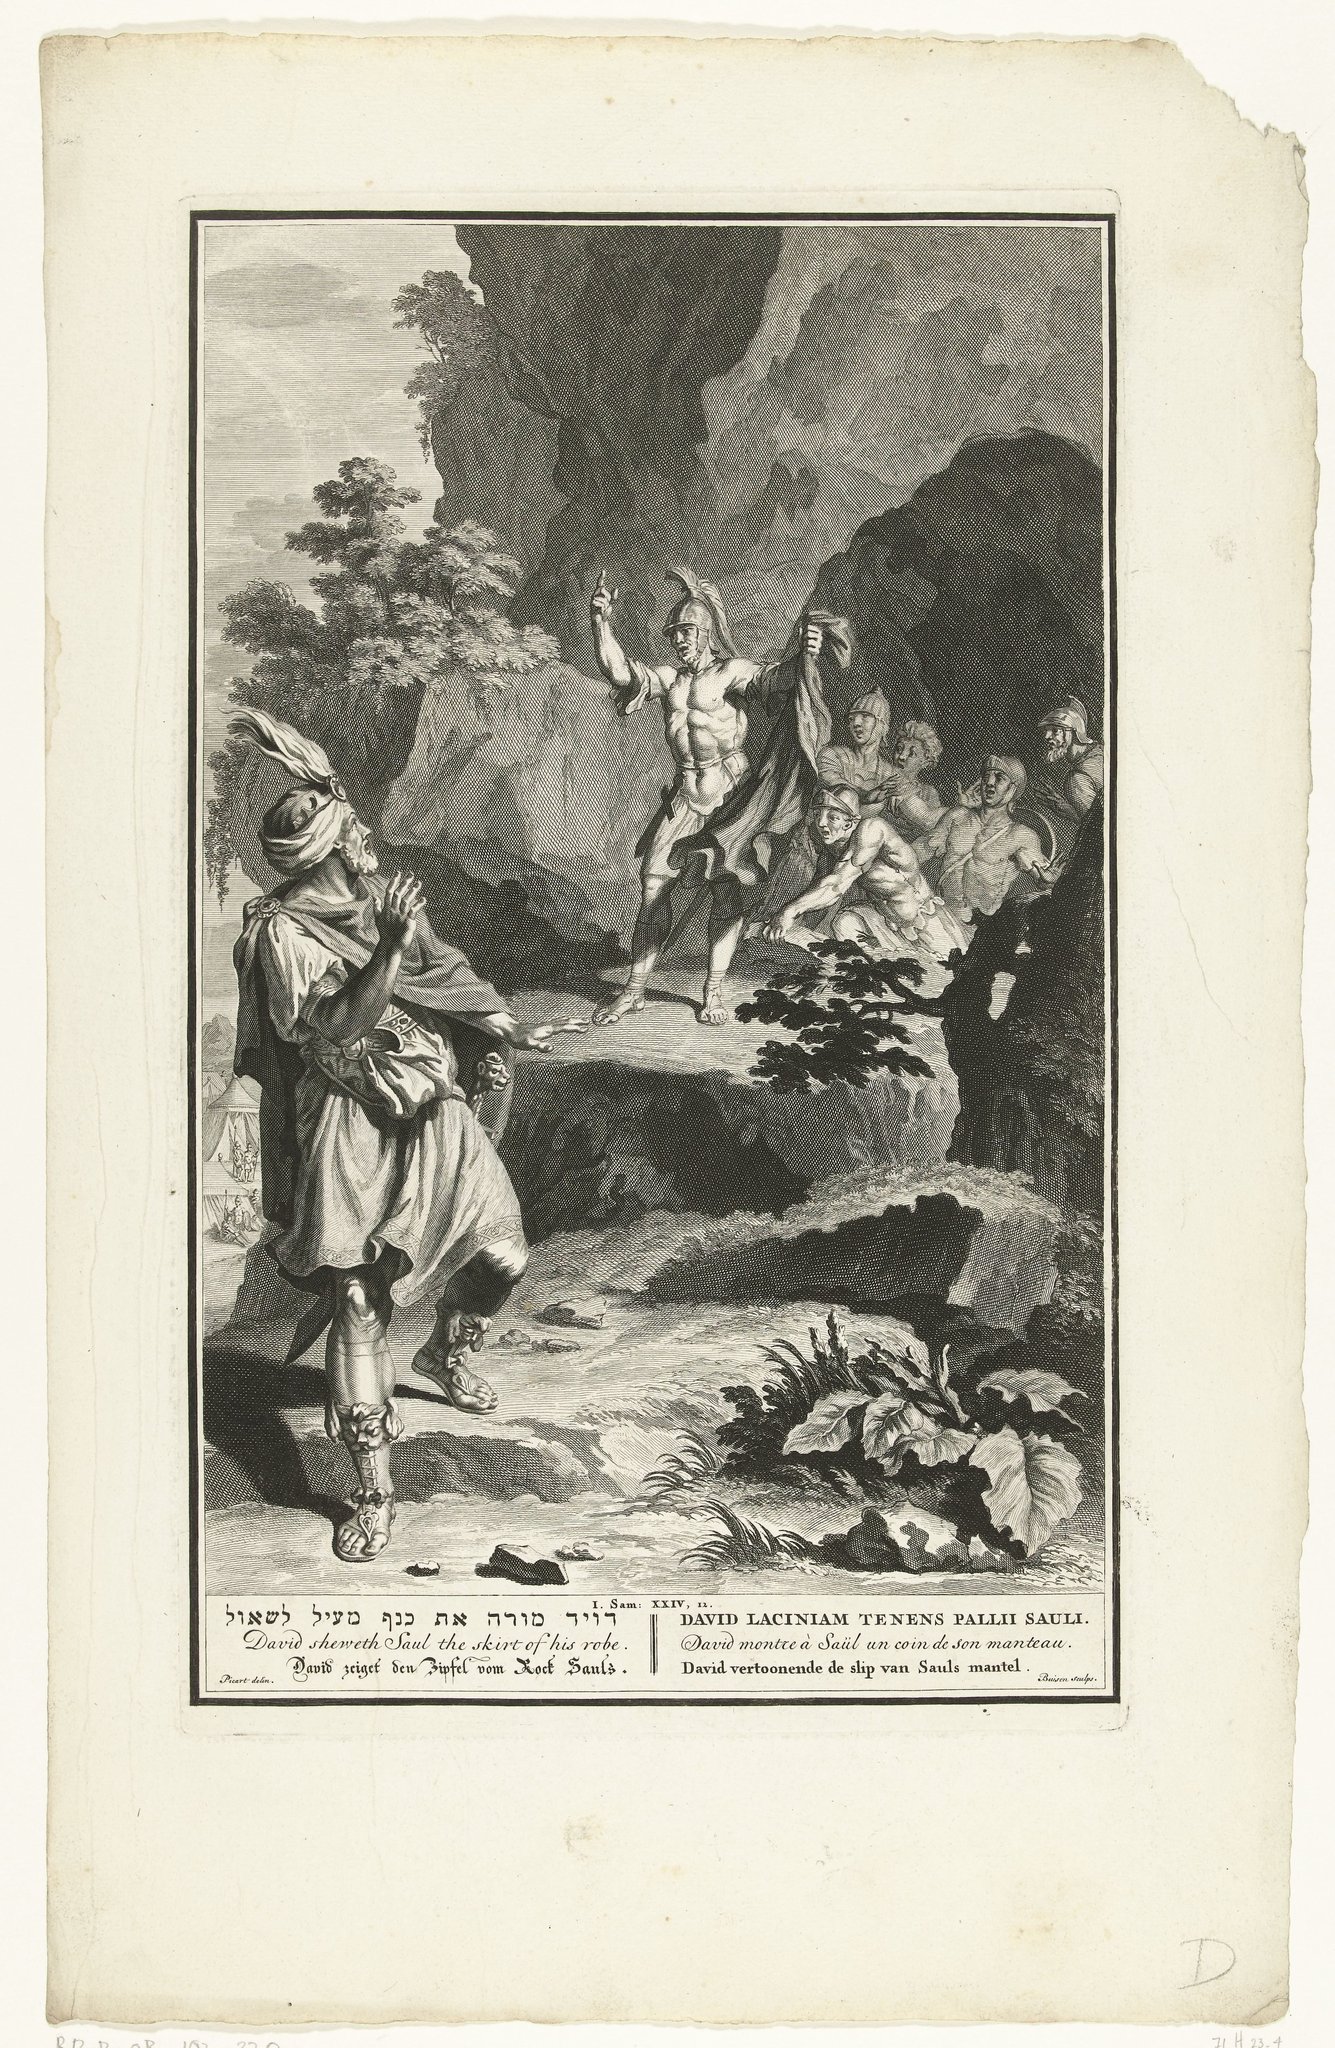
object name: book illustration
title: David toont Saul het stuk van zijn mantel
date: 1711-1720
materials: paper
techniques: engraving, etching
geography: amsterdam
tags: when saul comes out of the cave, david calls him, falls down on his knees and shows him the piece of cloth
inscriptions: collector's mark: 2228, collector's mark: Lugt Utrechts Fundatie Huys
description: David weerhoudt zijn mannen ervan om Saul te doden. Hij toont de verraste Saul een stuk van diens mantel dat hij eerder afgesneden heeft. Illustratie voor het Oude Testament, I Sam 24:12. Onder de voorstelling een titel in het Hebreeuws, Engels, Duits, Latijn, Frans en Nederlands.